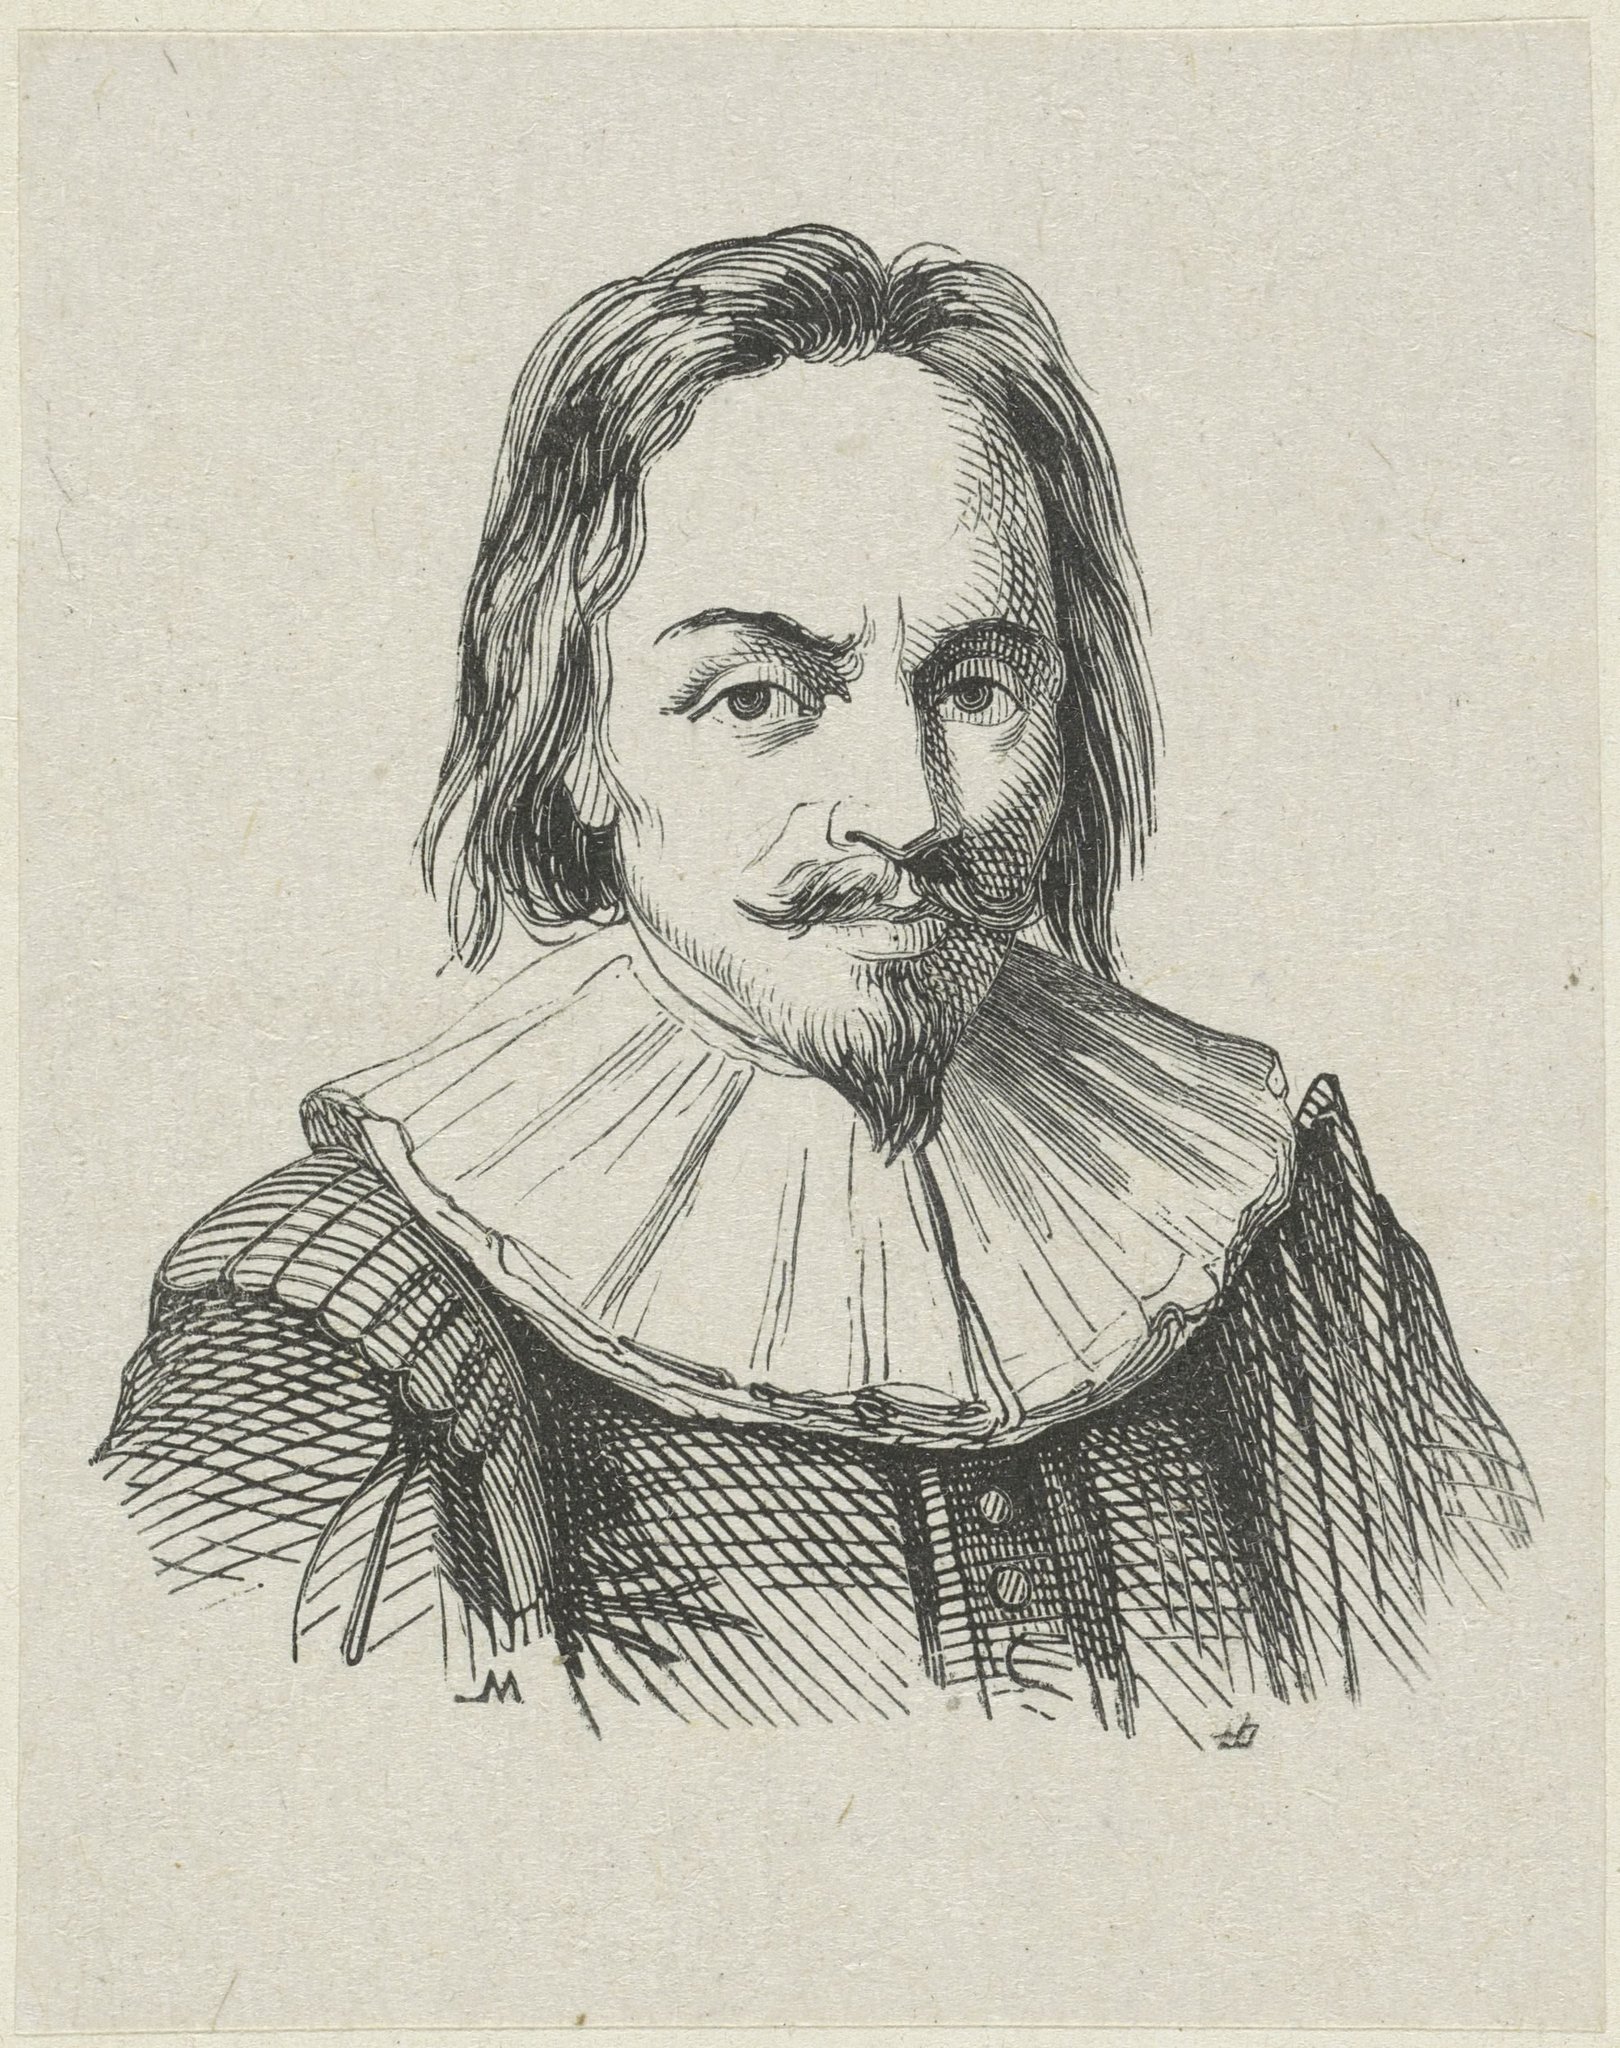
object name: print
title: Portret van Pieter Saenredam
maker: monogrammist ml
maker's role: print maker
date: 1800-1900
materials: paper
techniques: engraving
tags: assendelft, haarlem, draughtsman, pieter jansz saenredam, historical persons, portrait, self-portrait of painter, portrait, self-portrait of artist